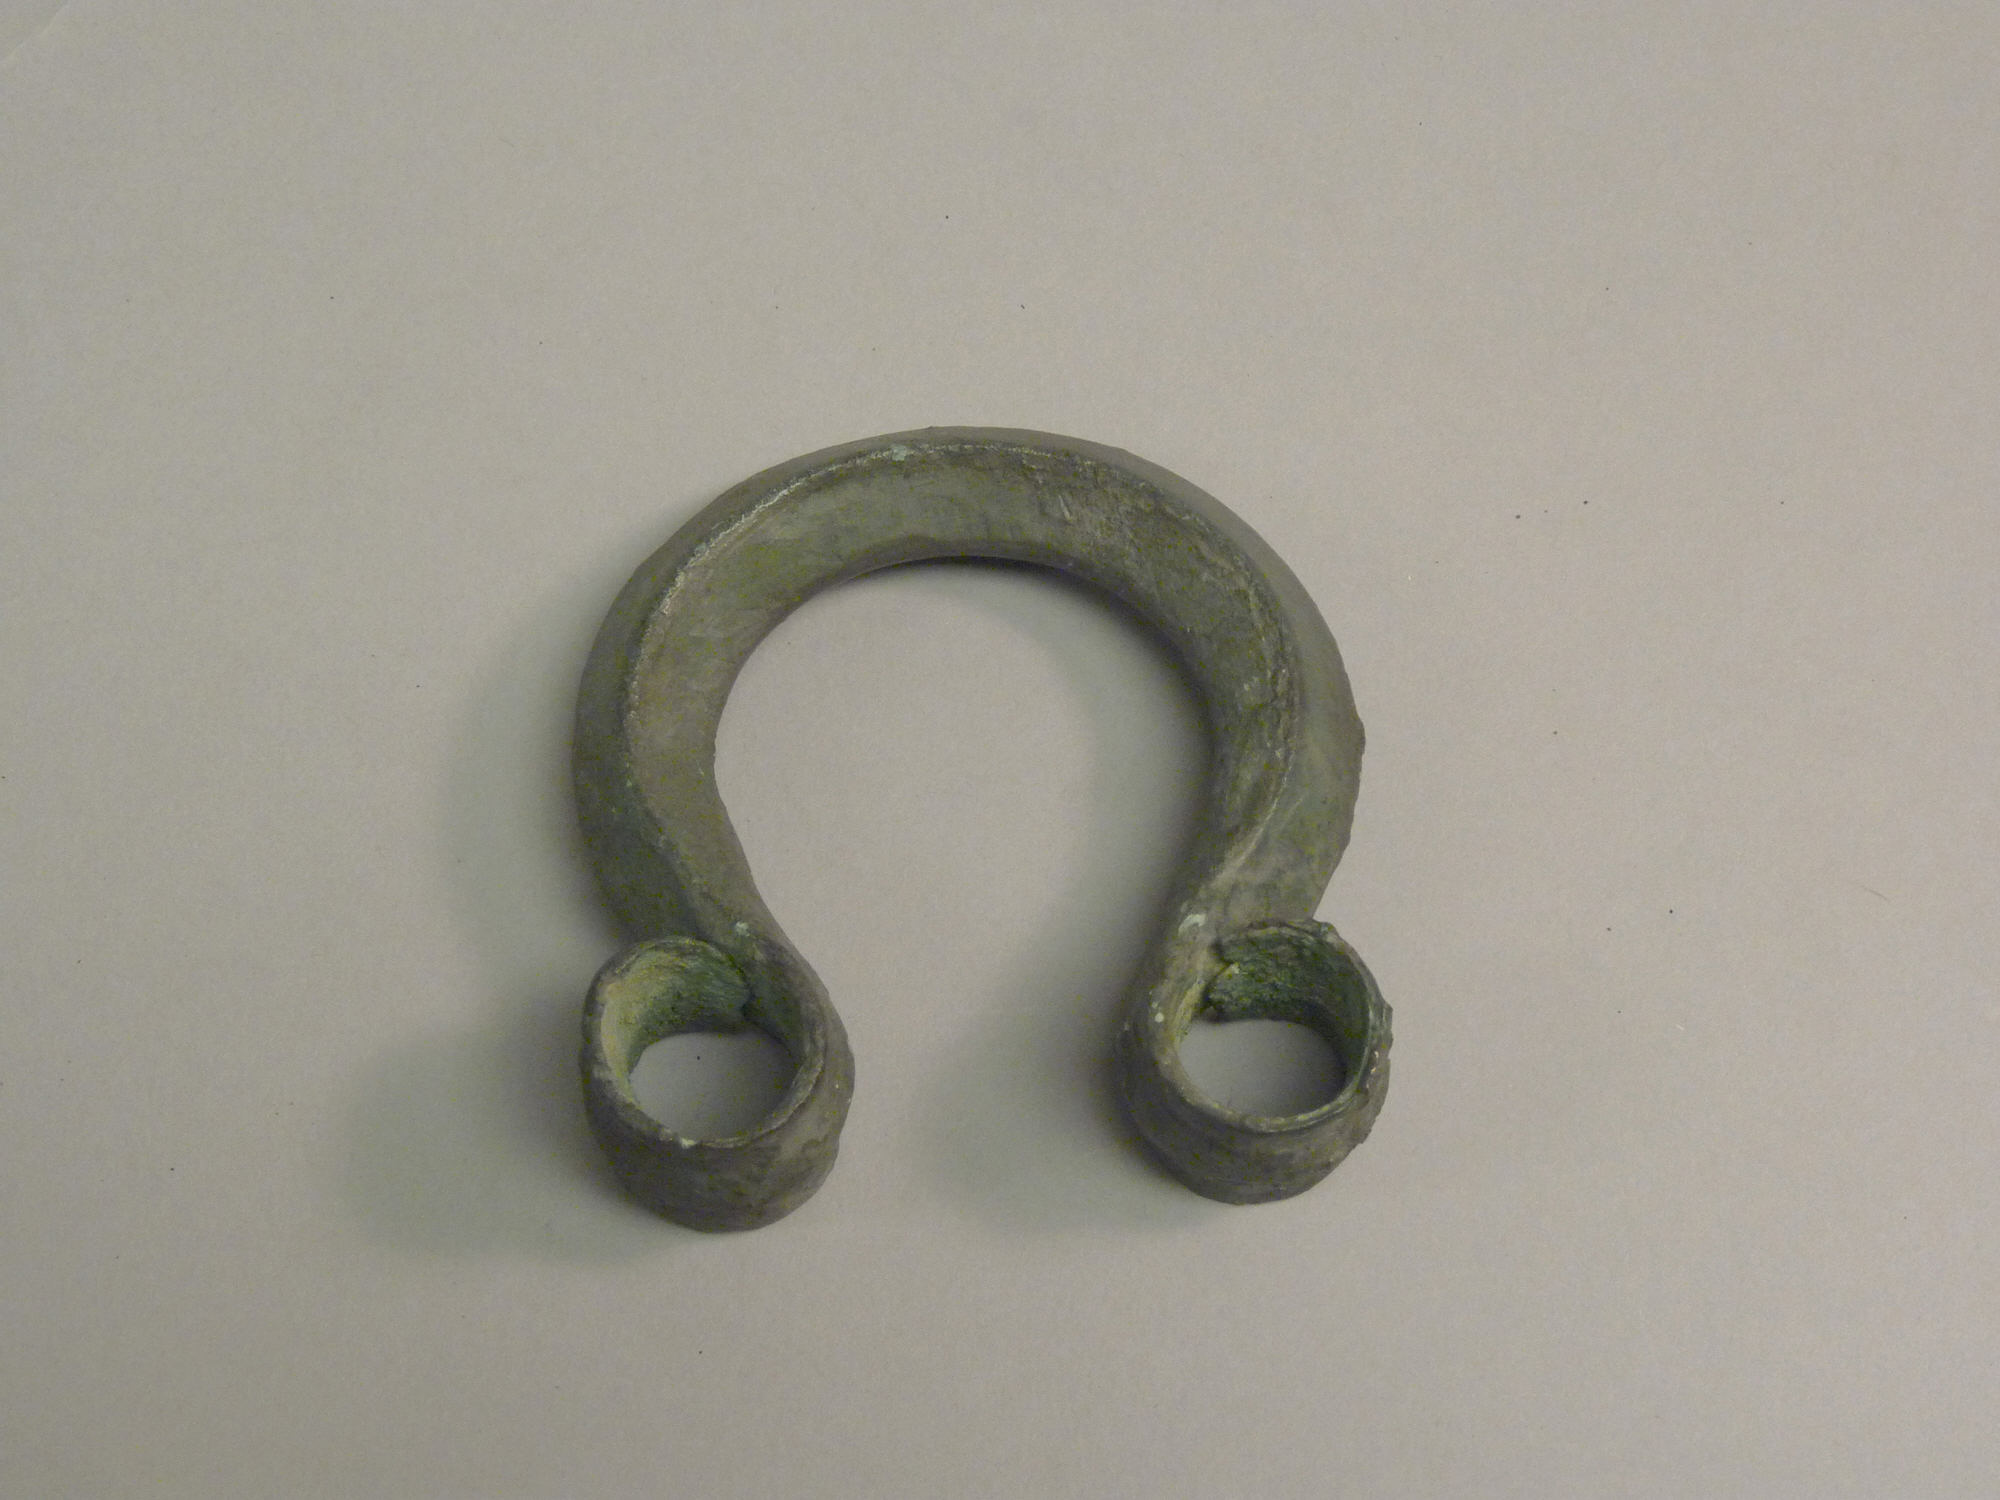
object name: one of a pair of bangle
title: One of a Pair of Bangles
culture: vietnamese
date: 500 BCE-300 CE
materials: bronze